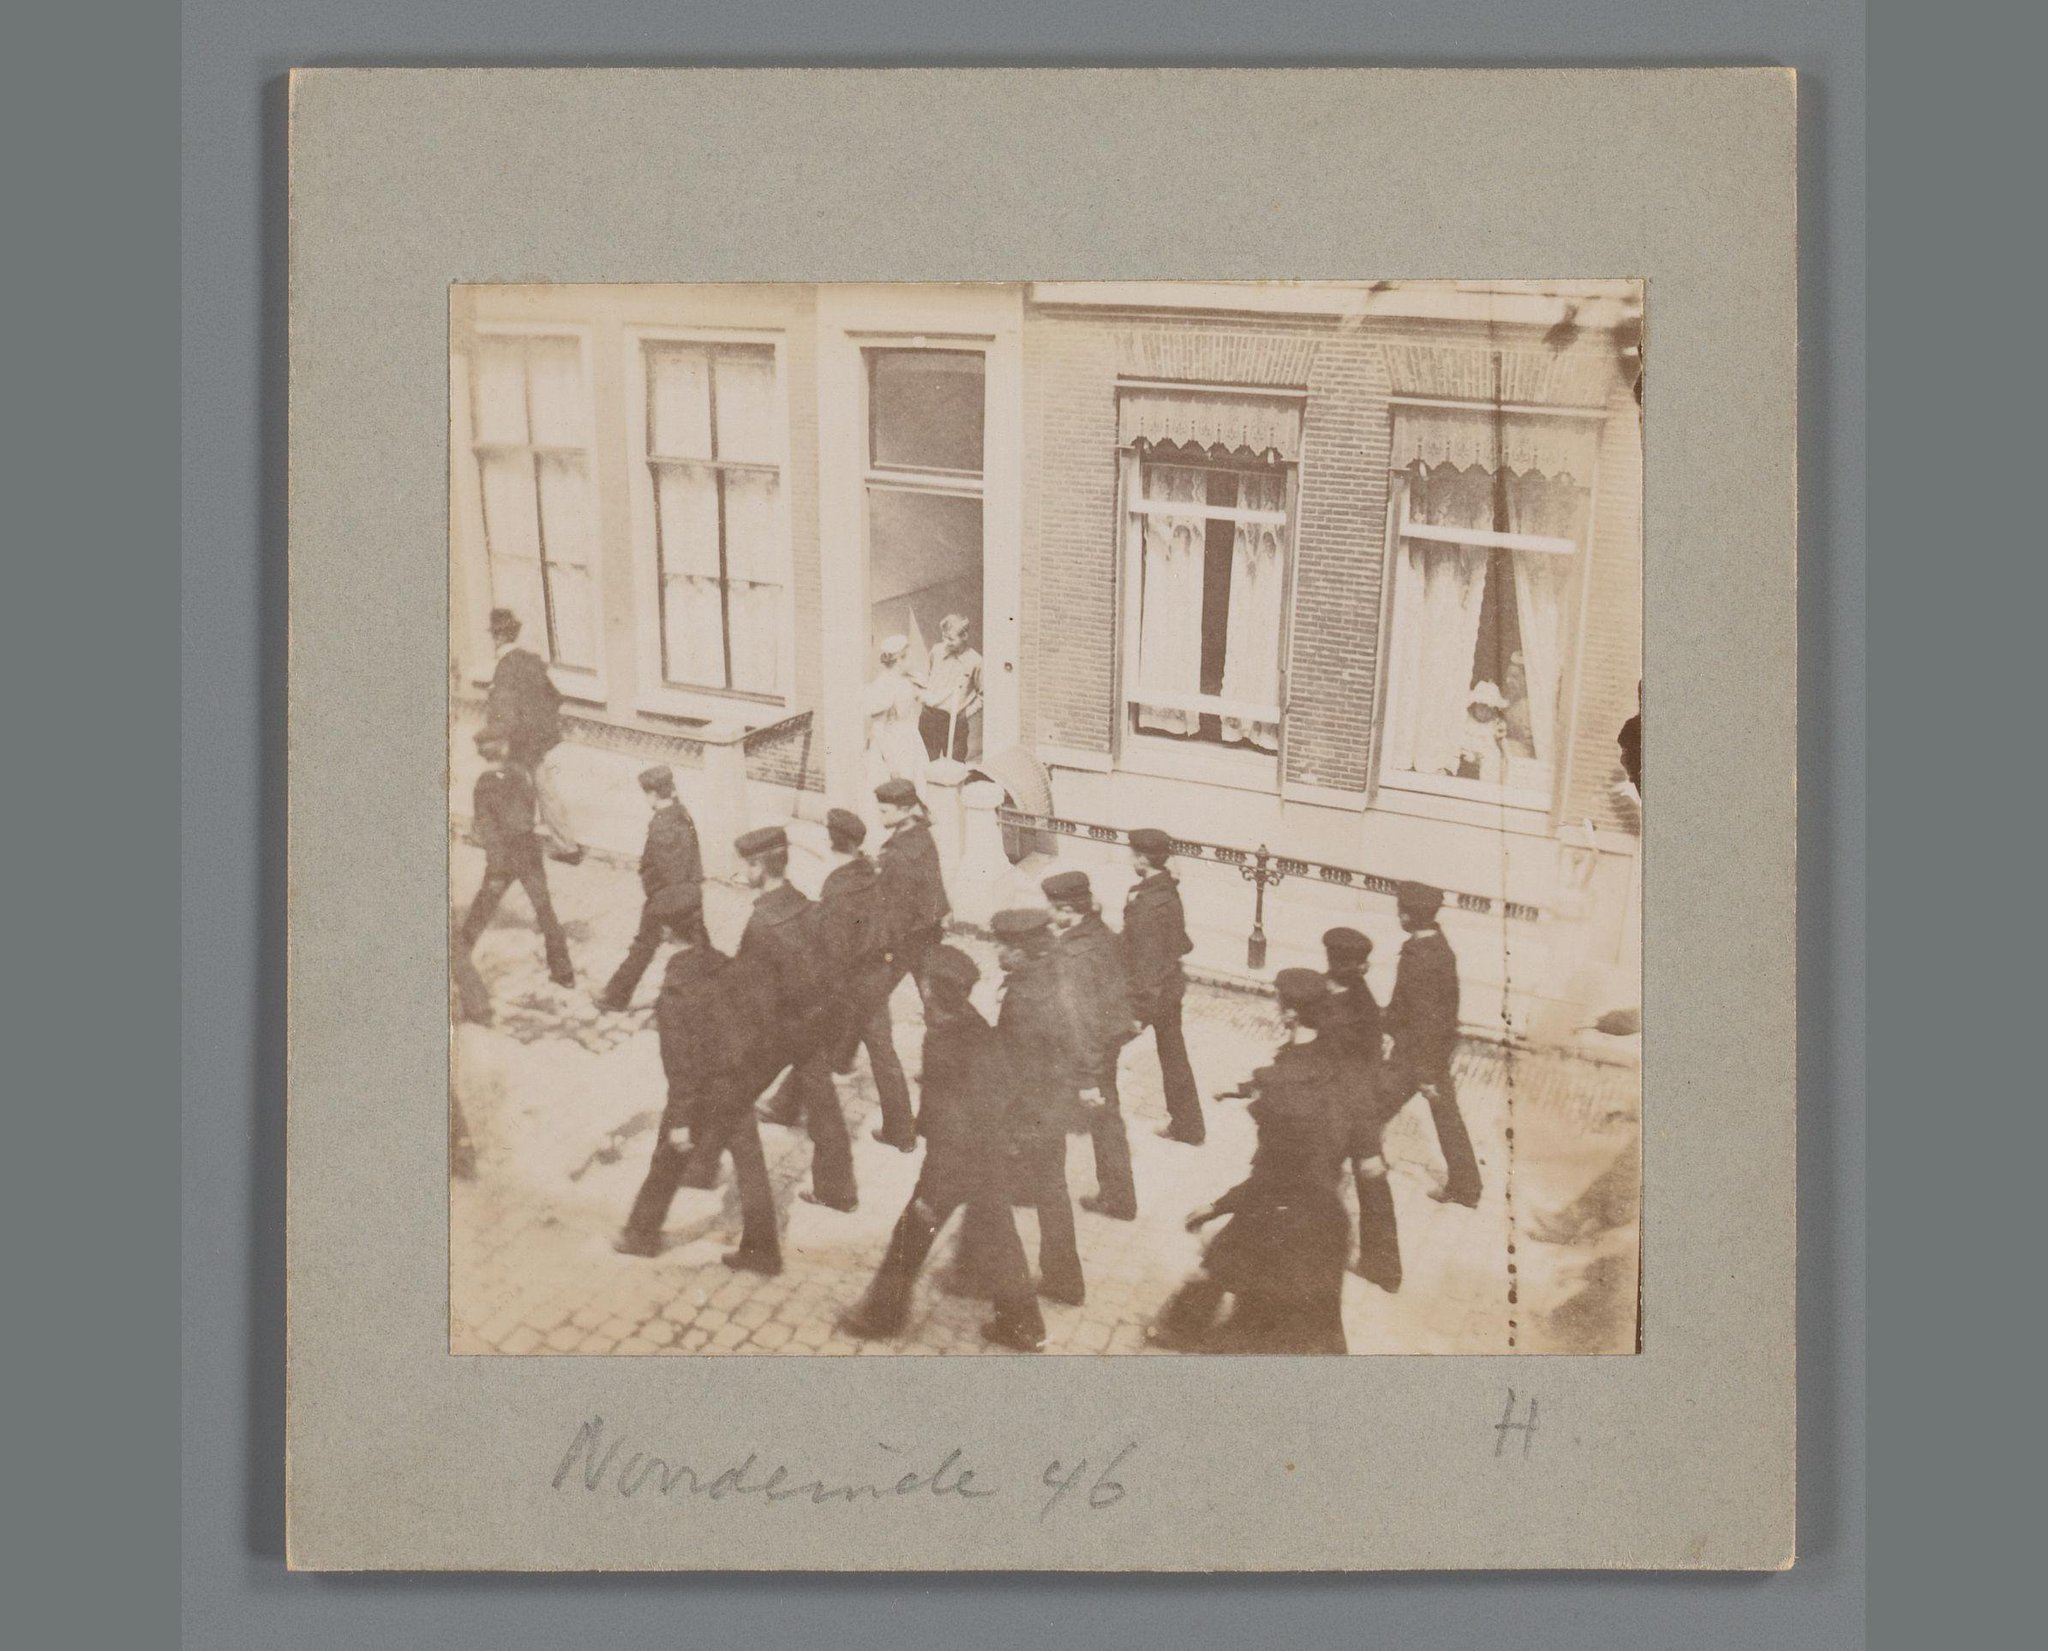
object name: photograph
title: Optocht met cadetten van de Kweekschool voor Zeevaart in Leiden met Johanna (Hans) de Jong in het raam van de woning aan het Noordeinde 46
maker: willem de jong (fotograaf)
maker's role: arts, fotograaf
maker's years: 1864-1918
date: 1896-1998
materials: paper, cardboard, ink, pencil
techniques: pen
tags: military parade, pageant, street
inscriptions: inscription: ‘defilé/ Kadetten/ Kweekschool/ v Zeevaart/ Leiden’, inscription: ‘H.’